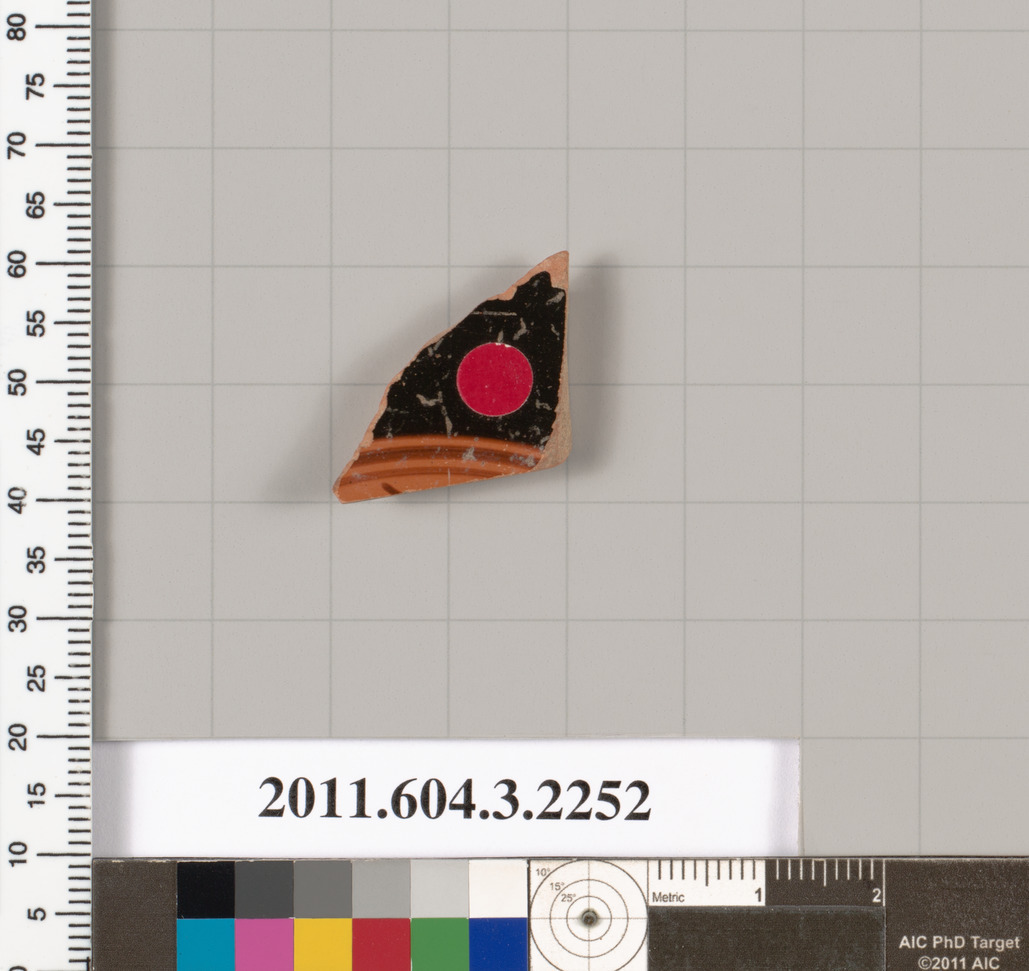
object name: kylix fragment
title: Terracotta fragment of a kylix (drinking cup)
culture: greek, attic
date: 600-401 BCE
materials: terracotta